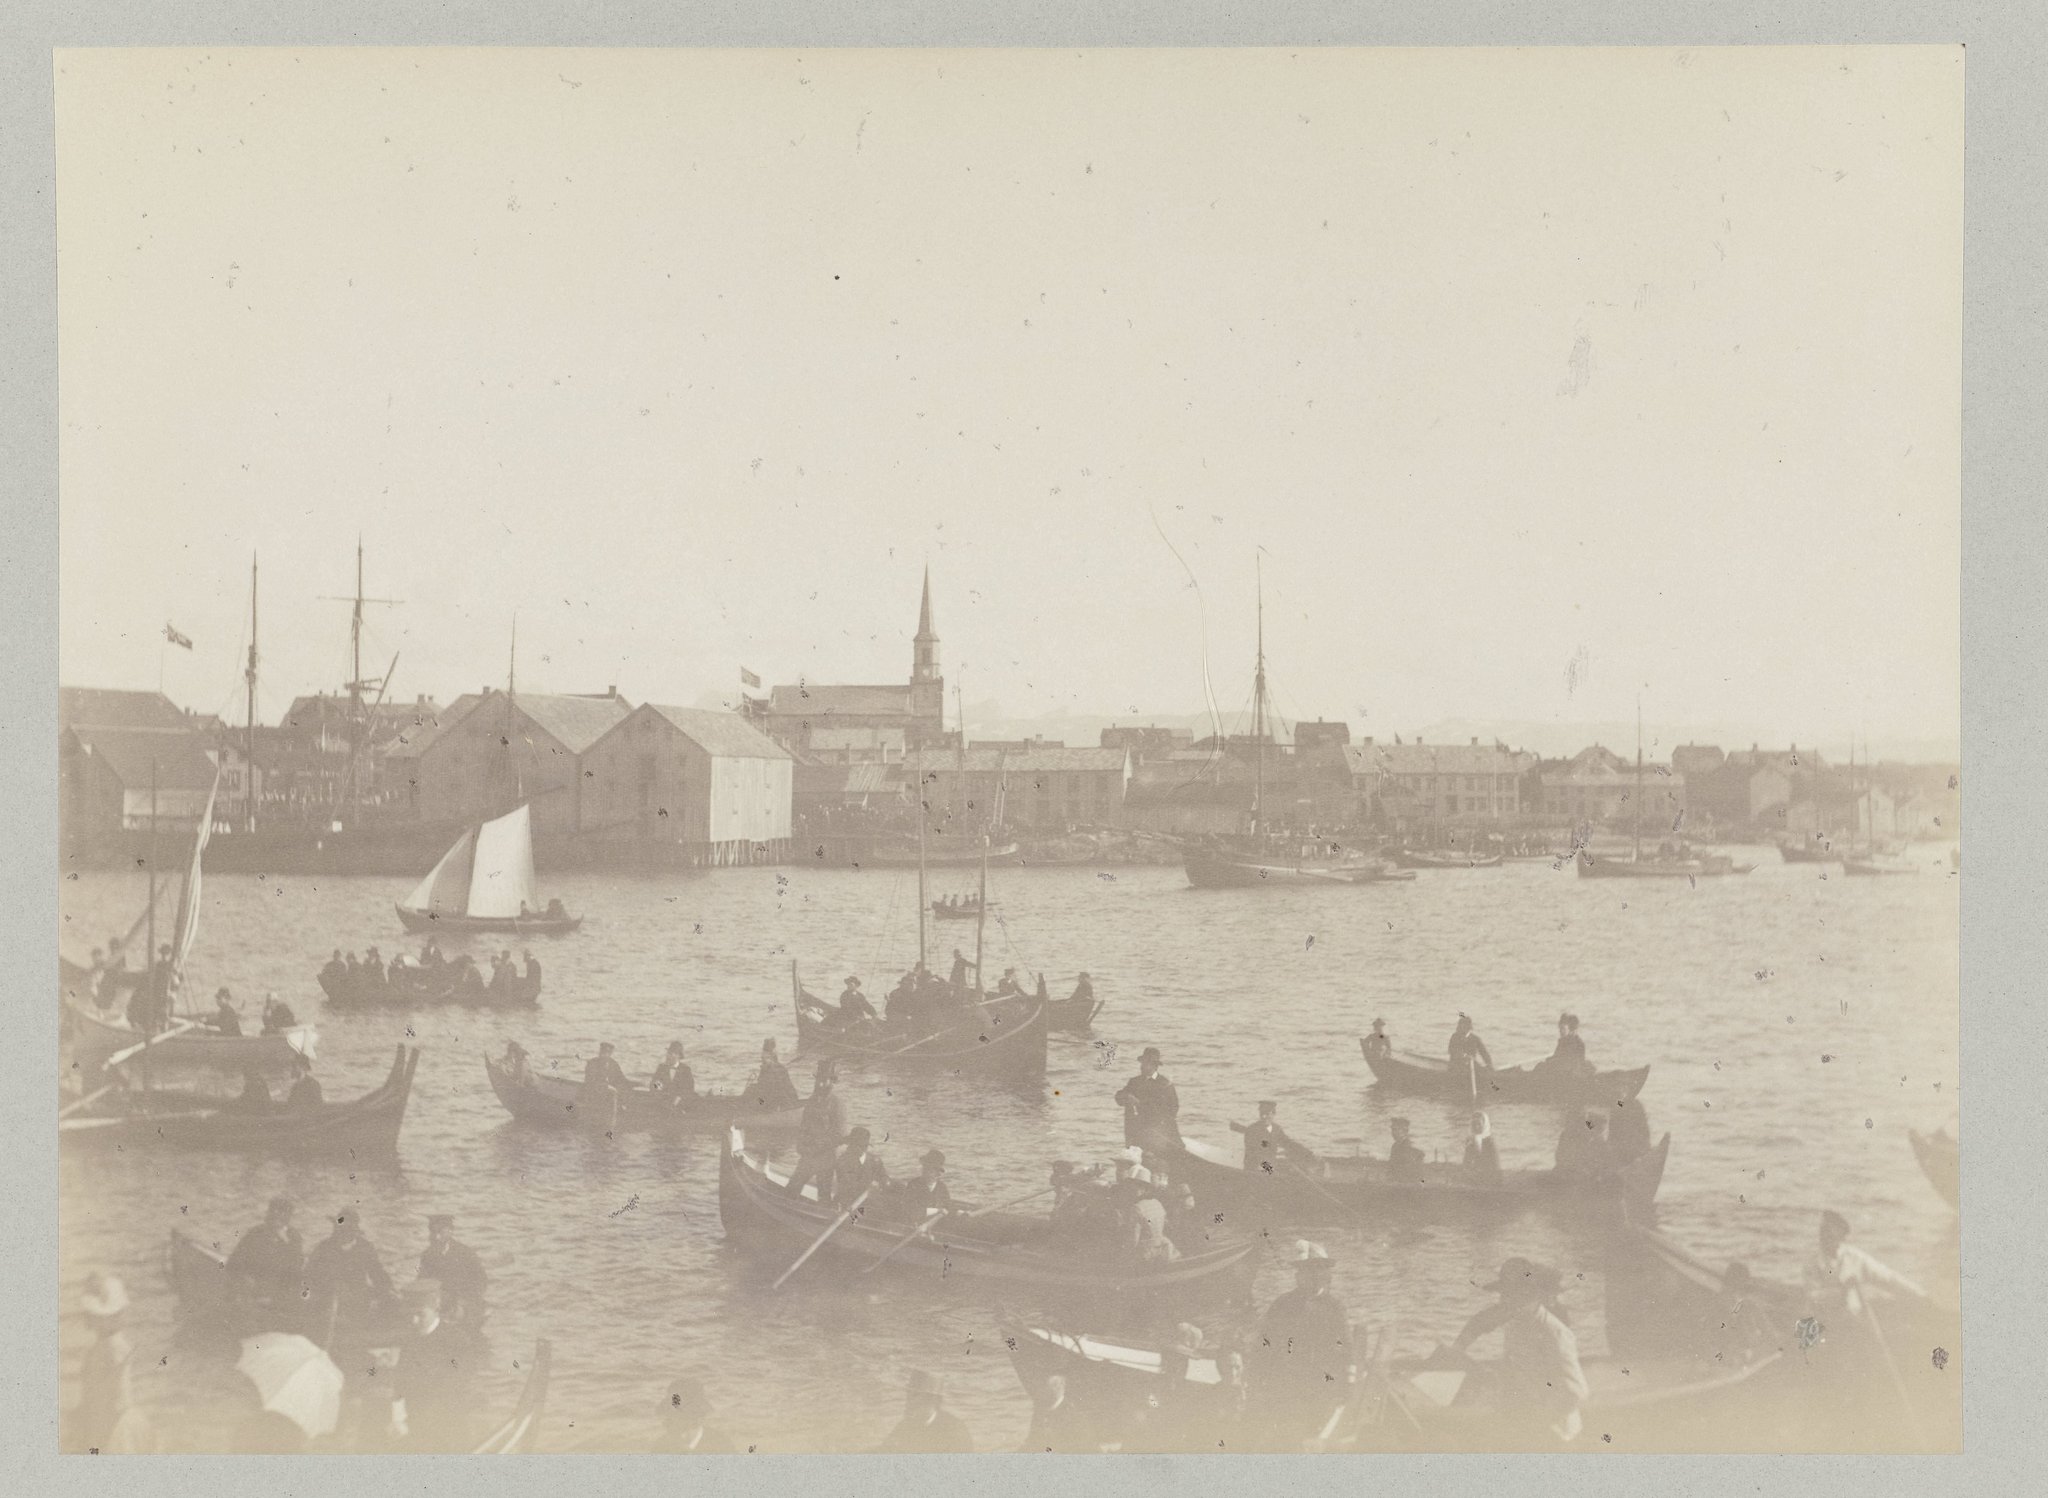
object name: photograph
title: Het schip de Hohenzollern omgeven door volle roeiboten in een haven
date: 1807-1889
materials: cardboard, paper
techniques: albumen print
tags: wilhelm ii (keizer van duitsland), norway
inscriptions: number: ‘79’, number: ‘24’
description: Maakt onderdeel uit van het album "Erinnerungen an Norwegen im Juli 1889"